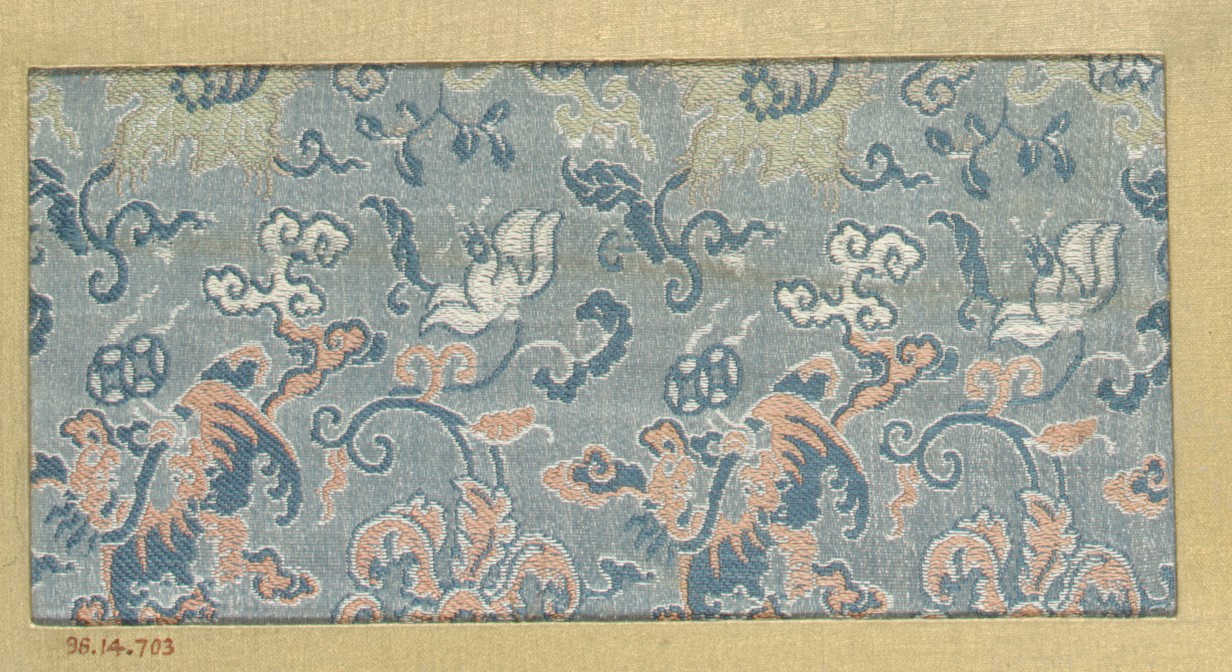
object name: piece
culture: japanese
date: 1701-1900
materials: silk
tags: flowers